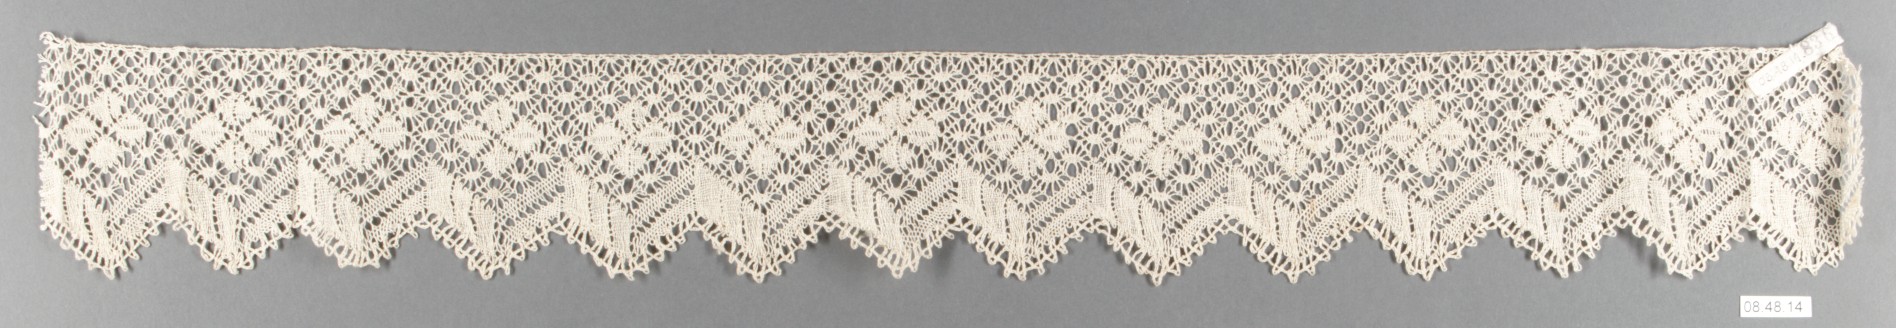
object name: edging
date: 1801-1900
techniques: lace